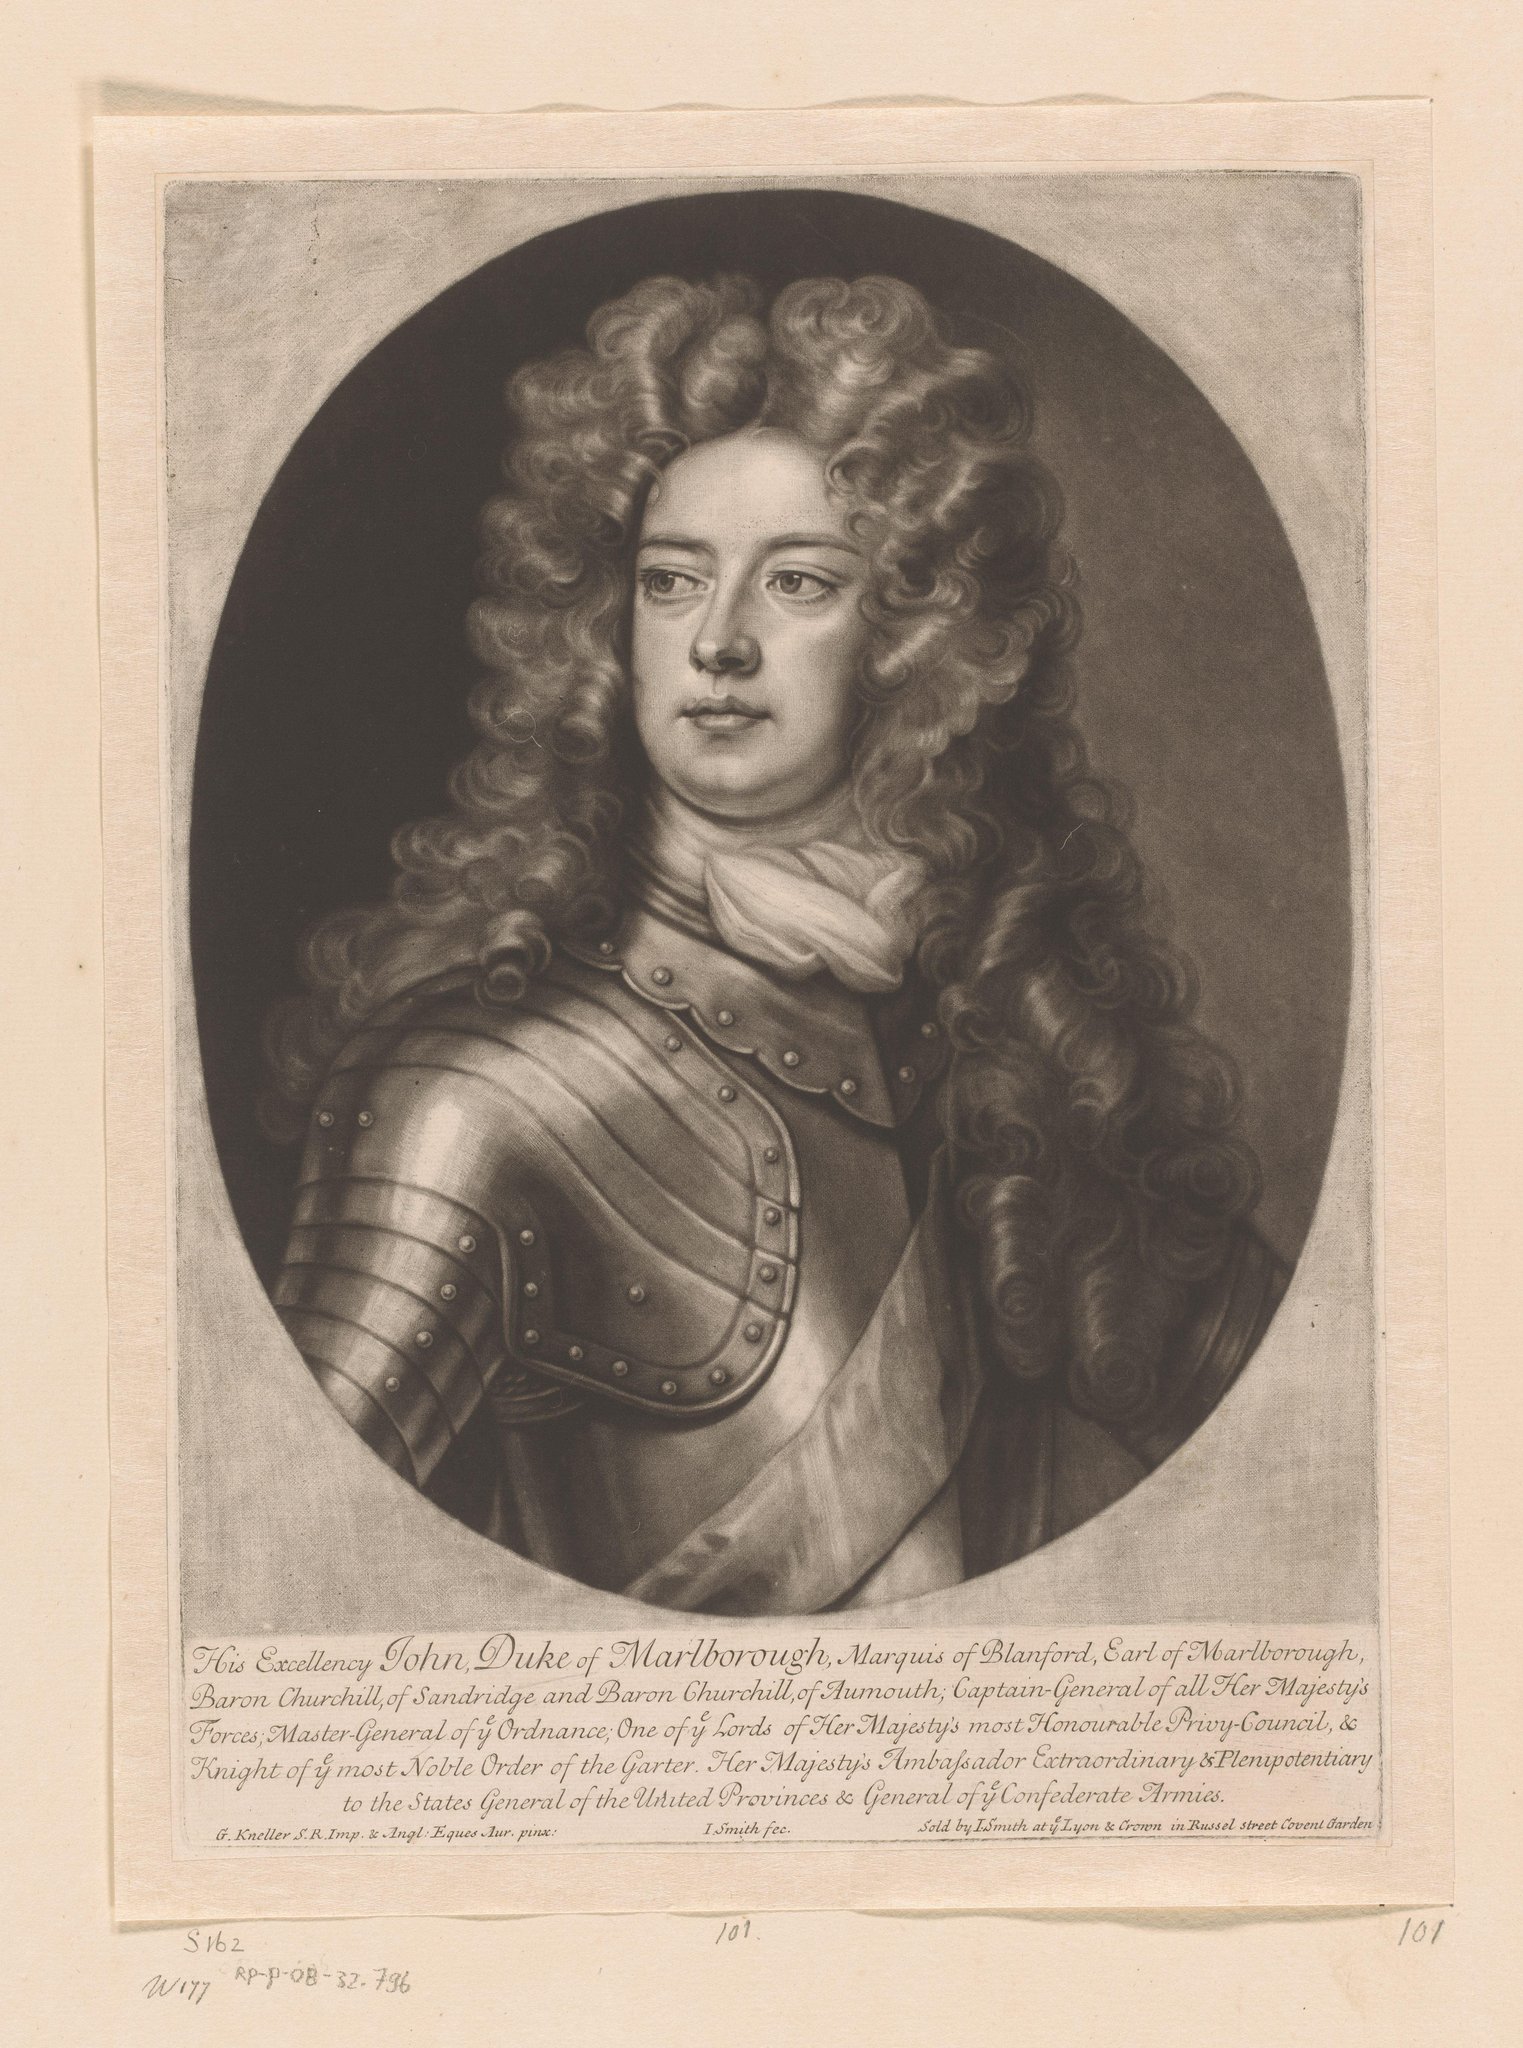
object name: print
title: Portret van John Churchill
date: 1702-1742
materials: paper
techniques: mezzotint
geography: london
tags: john churchill (1e hertog van marlborough), commander-in-chief, general, marshal, historical persons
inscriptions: collector's mark: Lugt 240